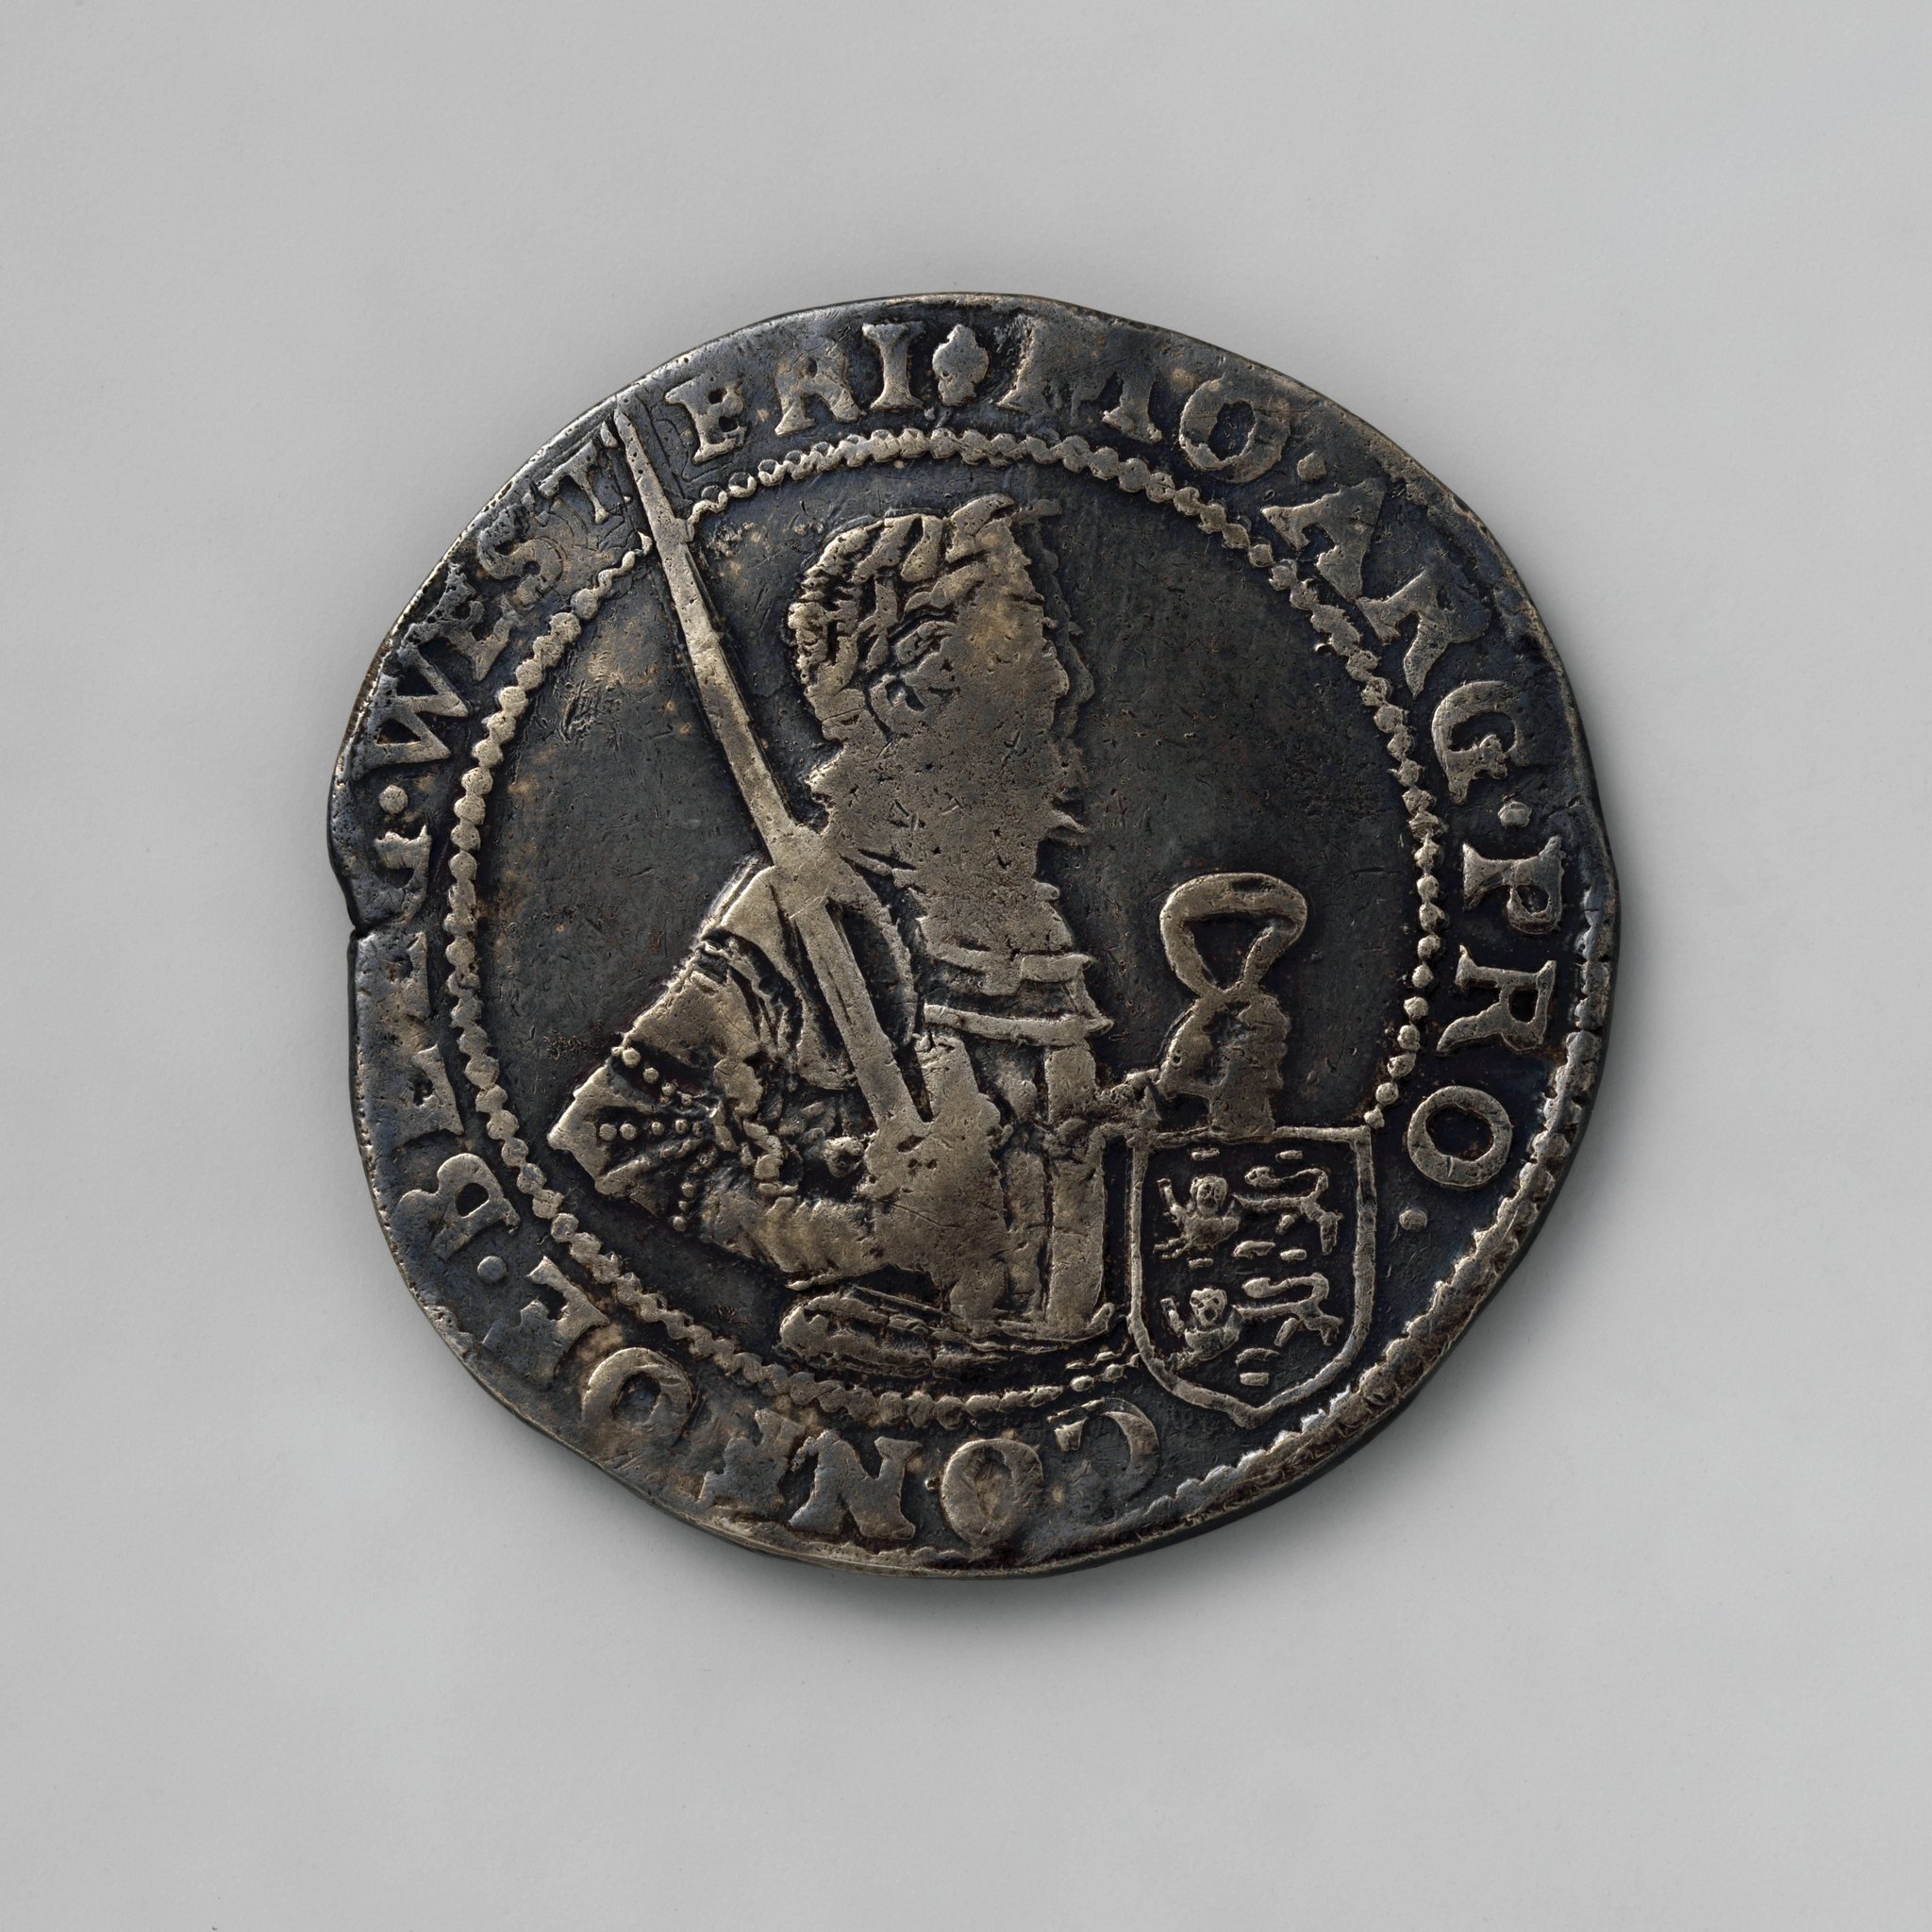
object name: coin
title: West-Friesland, Nederlandse rijksdaalder, 1619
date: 1619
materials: silver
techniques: striking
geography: west frisia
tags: west-friesland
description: Voorzijde: gelauwerd en geharnast borstbeeld naar rechts met zwaard in de rechter- en wapenschild van West-Friesland aan lint in linkerhand. Keerzijde: tussen jaartal gekroond generaliteitswapenschild.